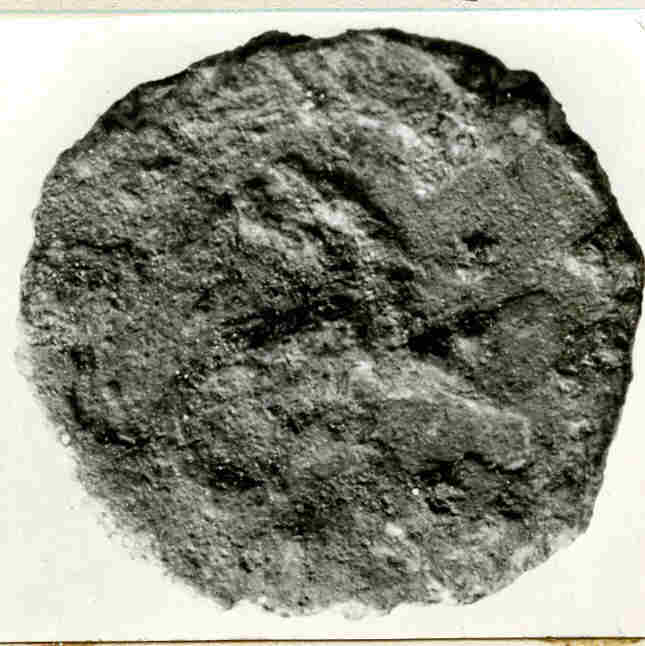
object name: coin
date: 797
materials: copper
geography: iran